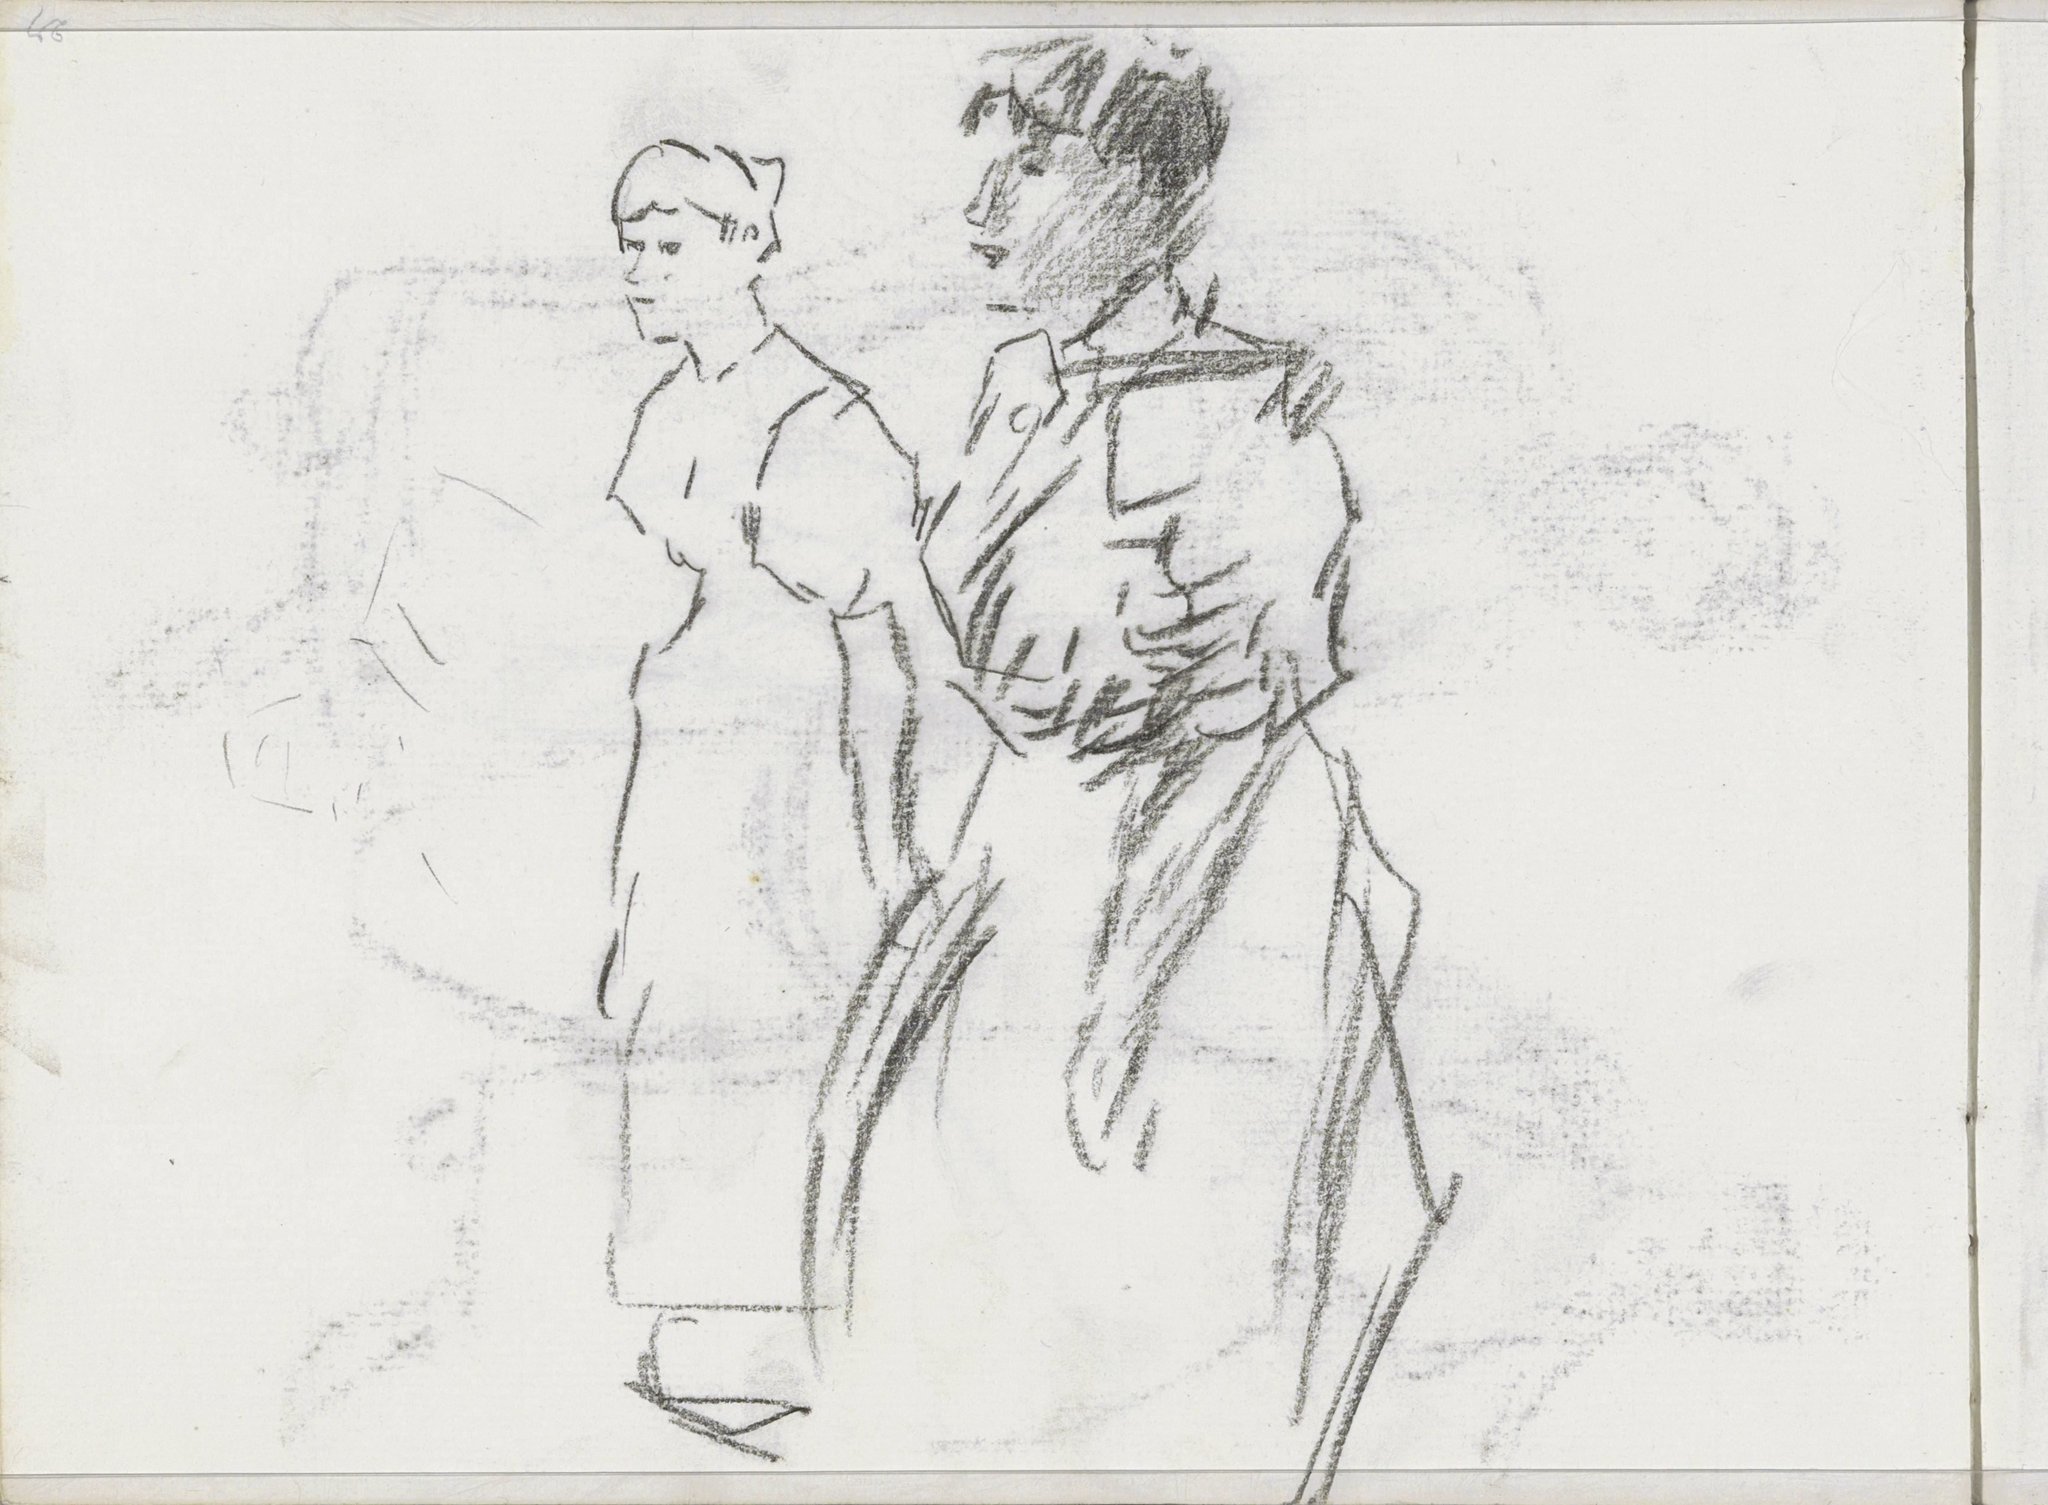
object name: sketchbook leaf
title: Twee staande vrouwen, in profiel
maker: isaac israels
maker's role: draughtsman, painter, print maker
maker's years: 1865-1934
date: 1875-1934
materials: chalk, paper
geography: amsterdam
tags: adult woman (+ standing)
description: Blad 24 verso uit schetsboek XX met 26 bladen.